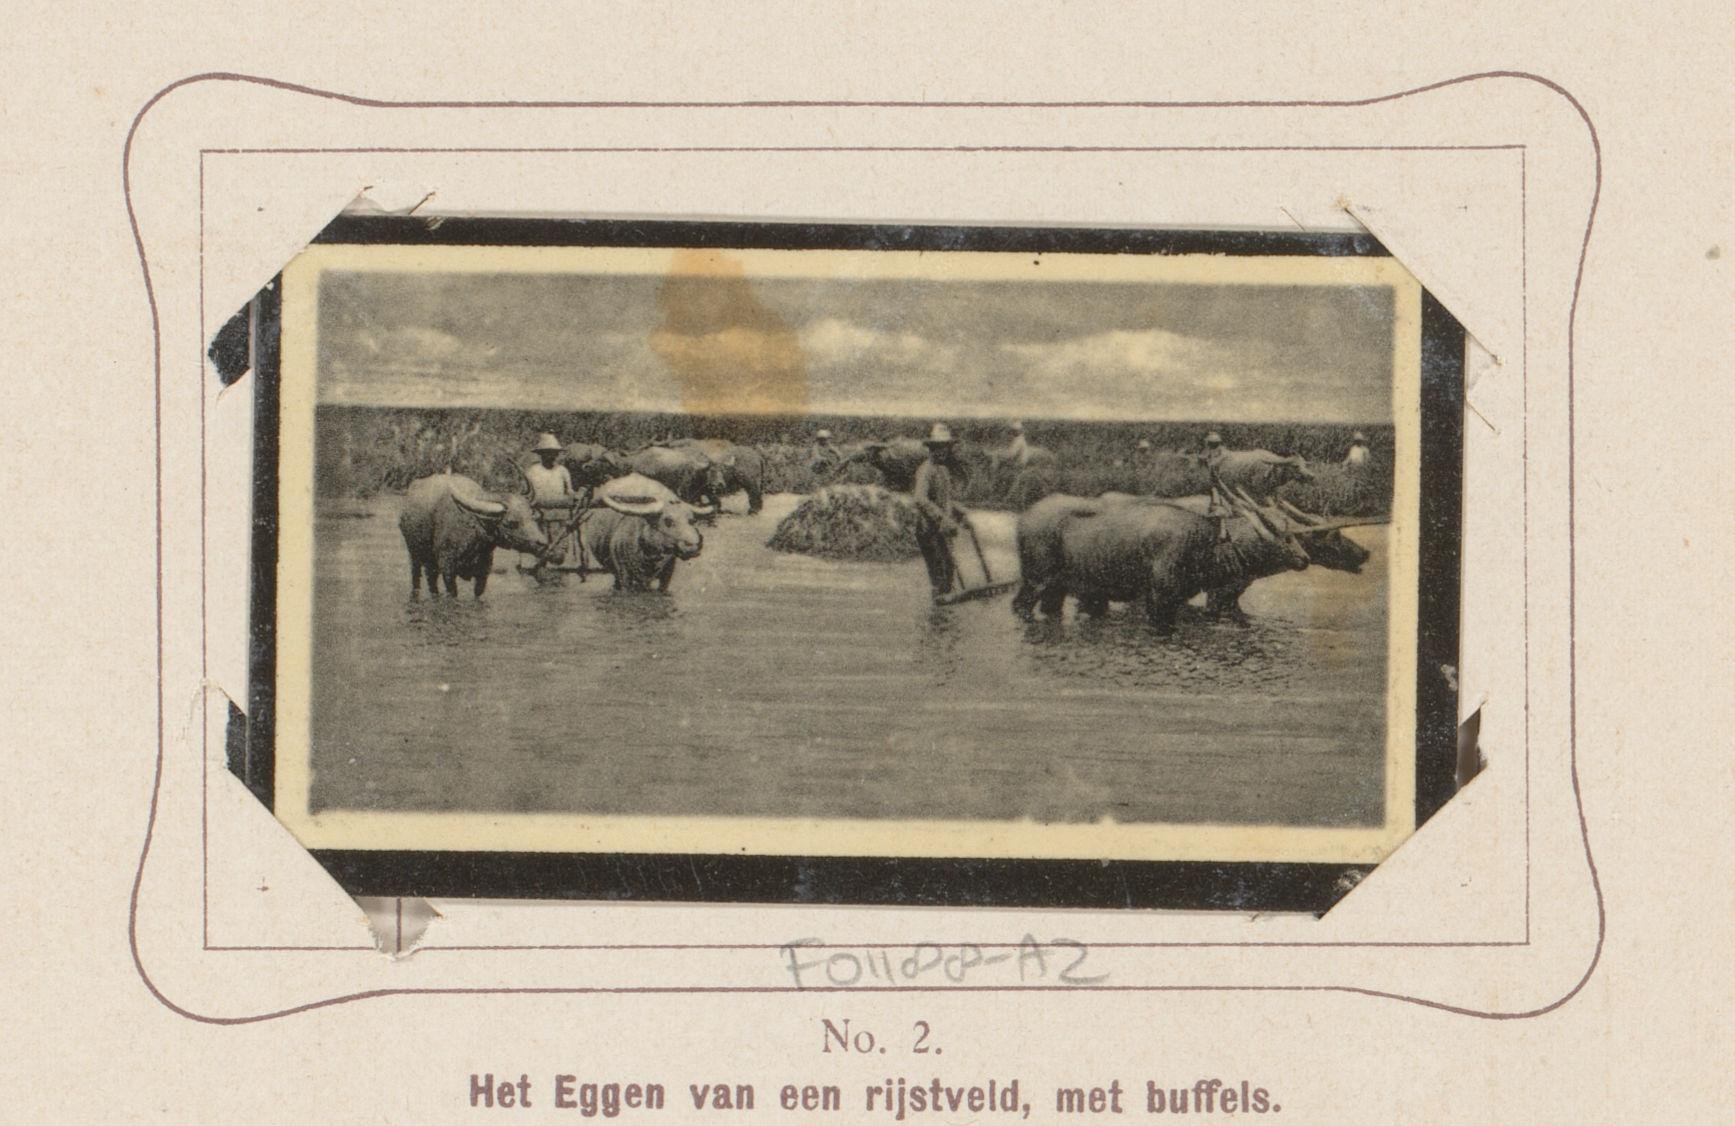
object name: album leaf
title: Boeren eggen een rijstveld met buffels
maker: Anonymous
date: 1906-1907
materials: paper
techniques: photograph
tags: hoofed animals: buffalo, sawahs, rice paddies, ploughing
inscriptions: inscription: ‘No. 2./ Het Eggen van een rijstveld, met buffels.’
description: Deze prent maakt deel uit van een album.